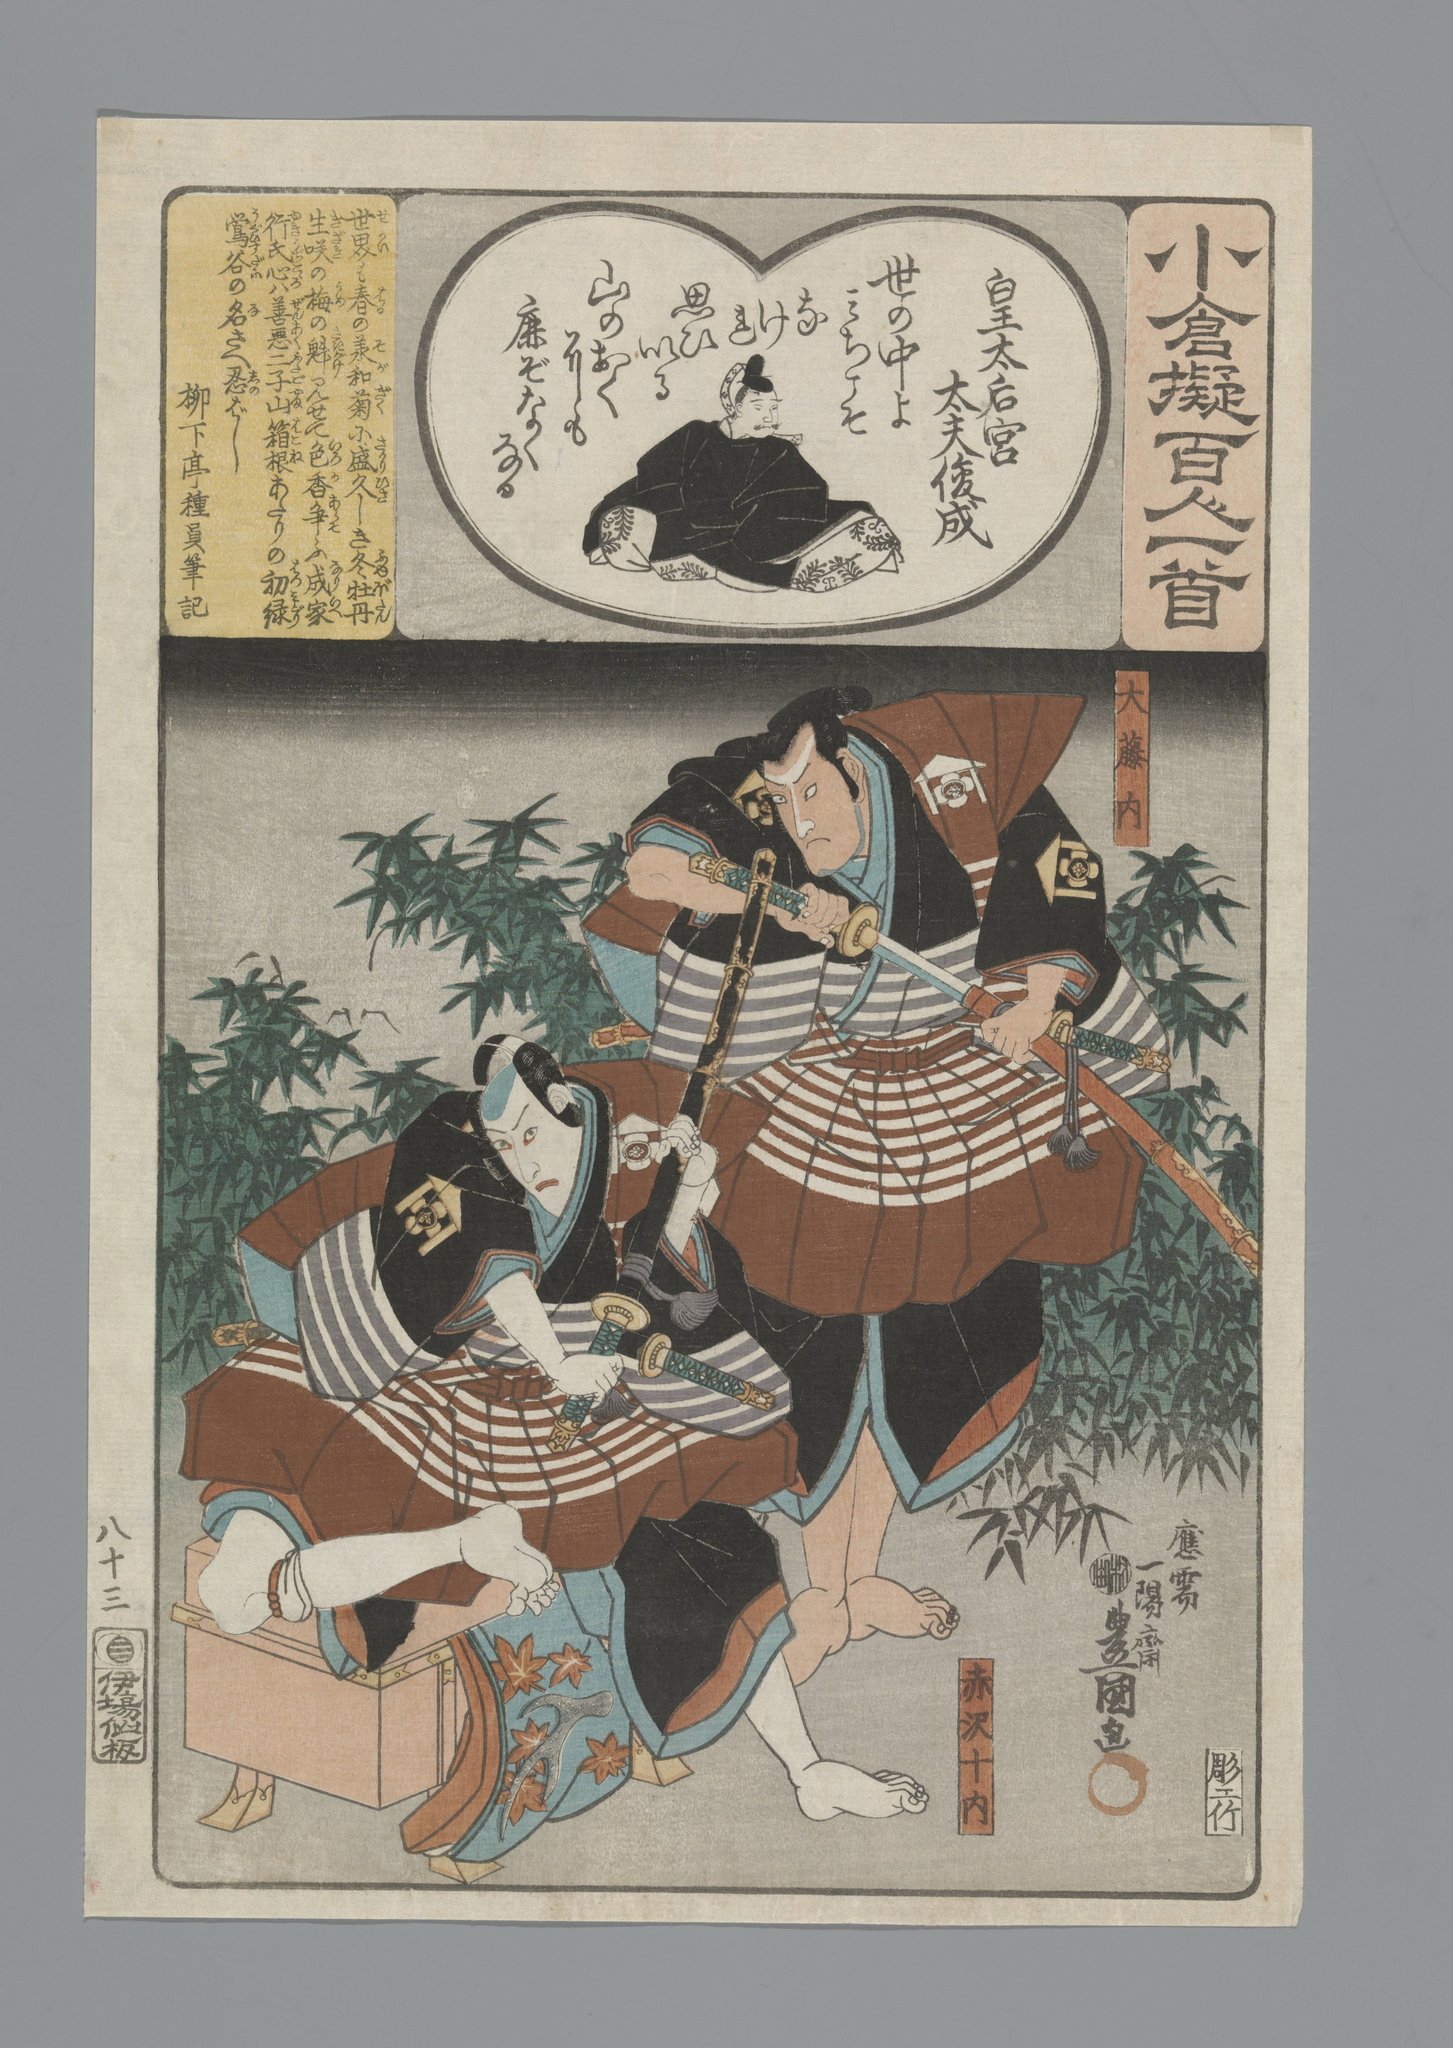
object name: print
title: Ogura Imitation of the One Hundred Poems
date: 1846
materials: paper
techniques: woodcut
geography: japan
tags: adult man (+ two persons), hacking and thrusting weapons: sword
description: Ôtônai trekt zijn zwaard terwijl Akazawa Jûnai op een kist zit. Scene uit een kabukitoneelstuk. Gedicht door Shunzei.